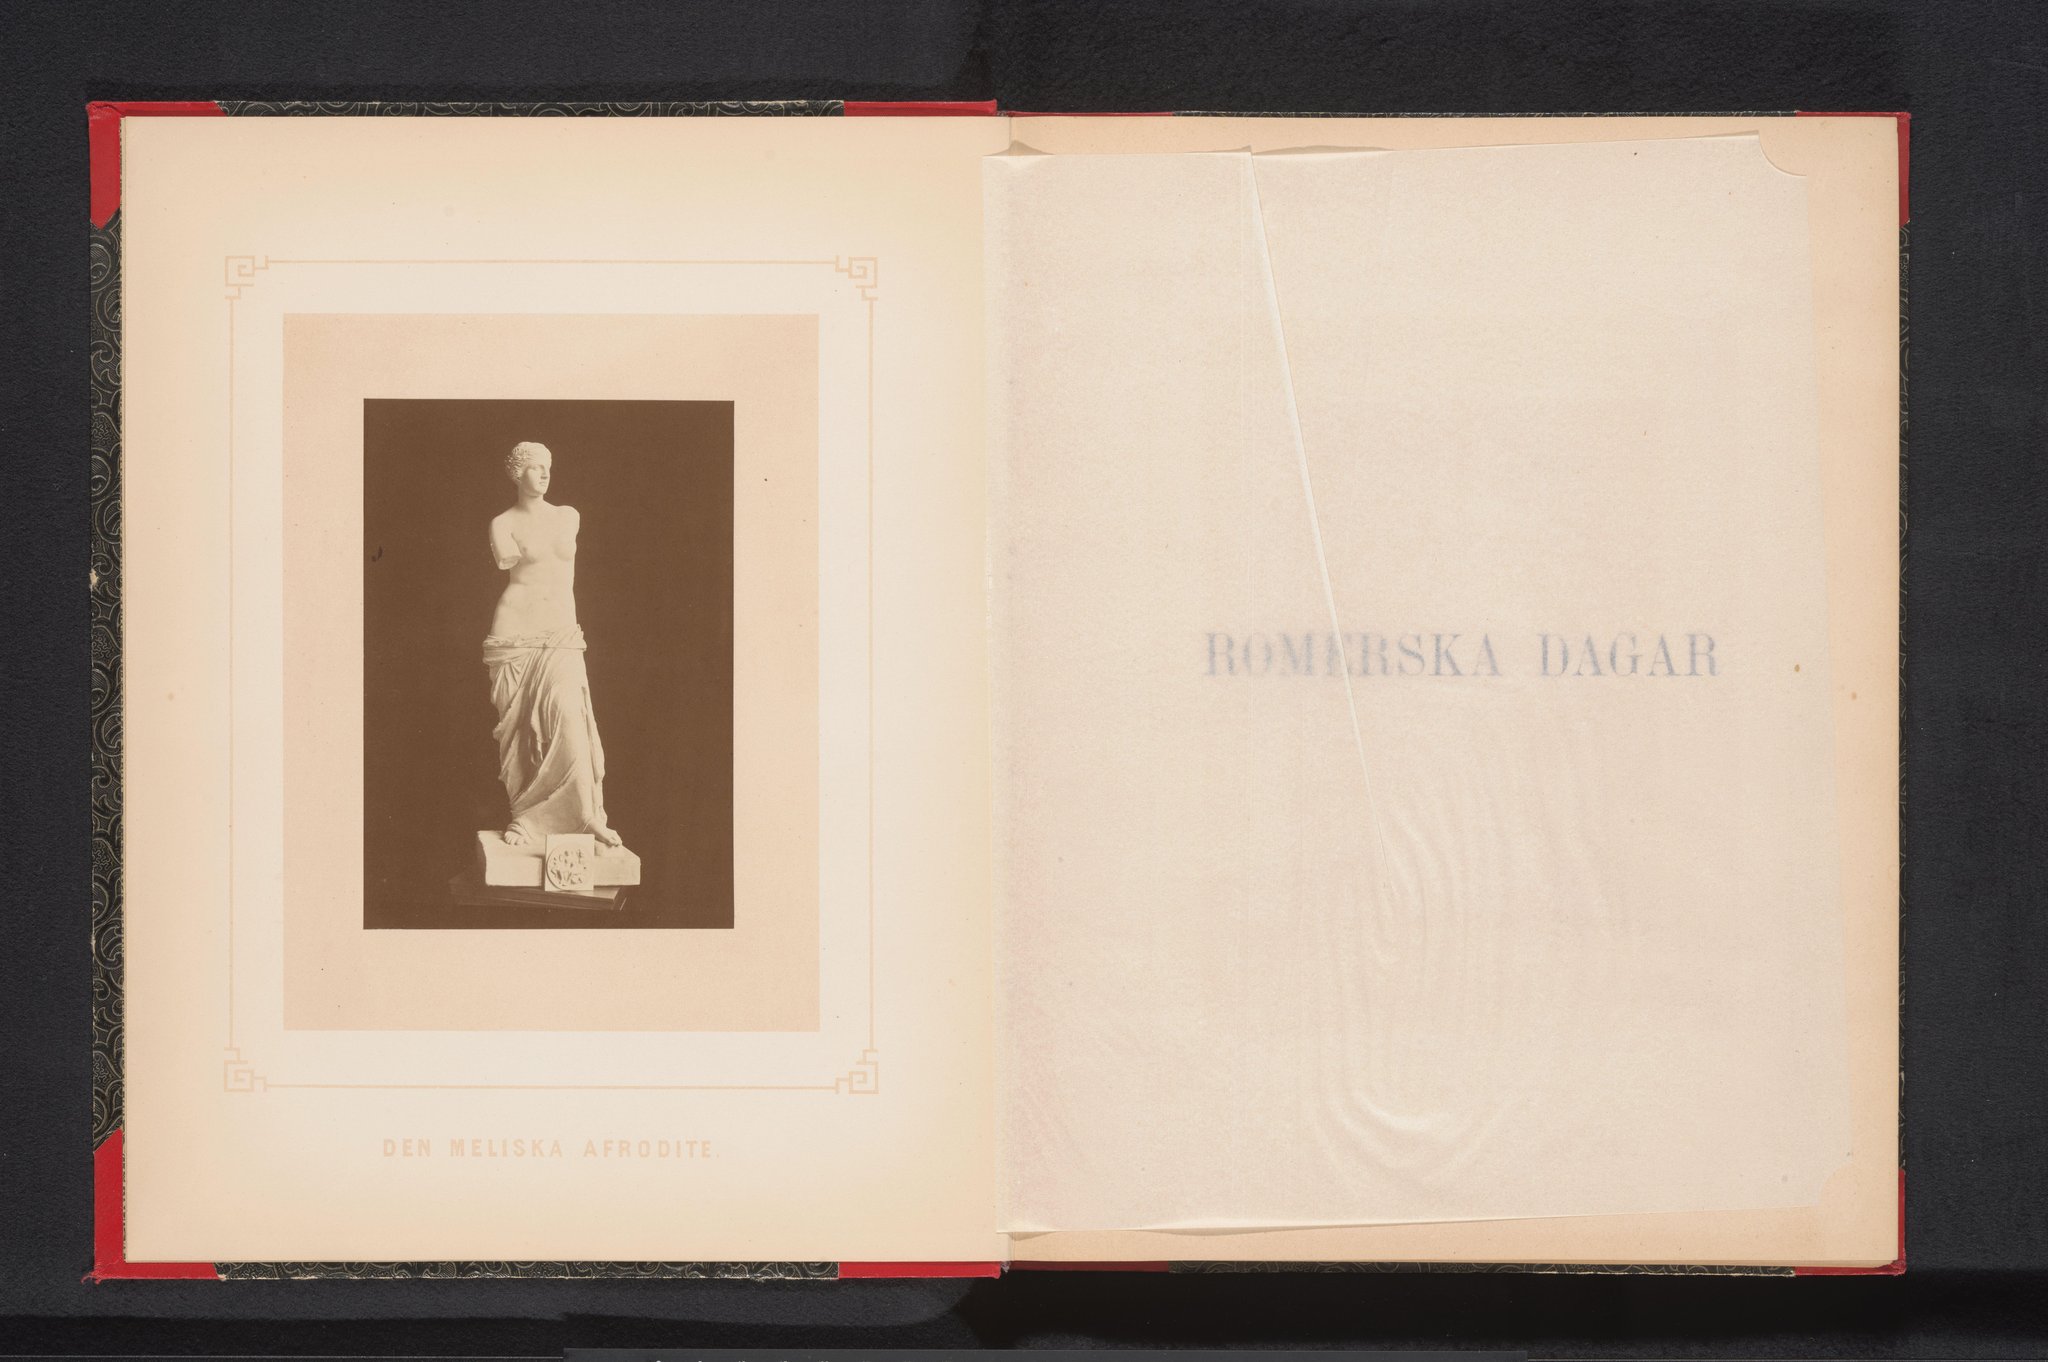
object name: photograph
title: Gipsafgietsel van de Venus van Milo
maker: Anonymous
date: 1867-1877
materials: photographic support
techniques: albumen print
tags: (story of) venus (aphrodite), sculpture